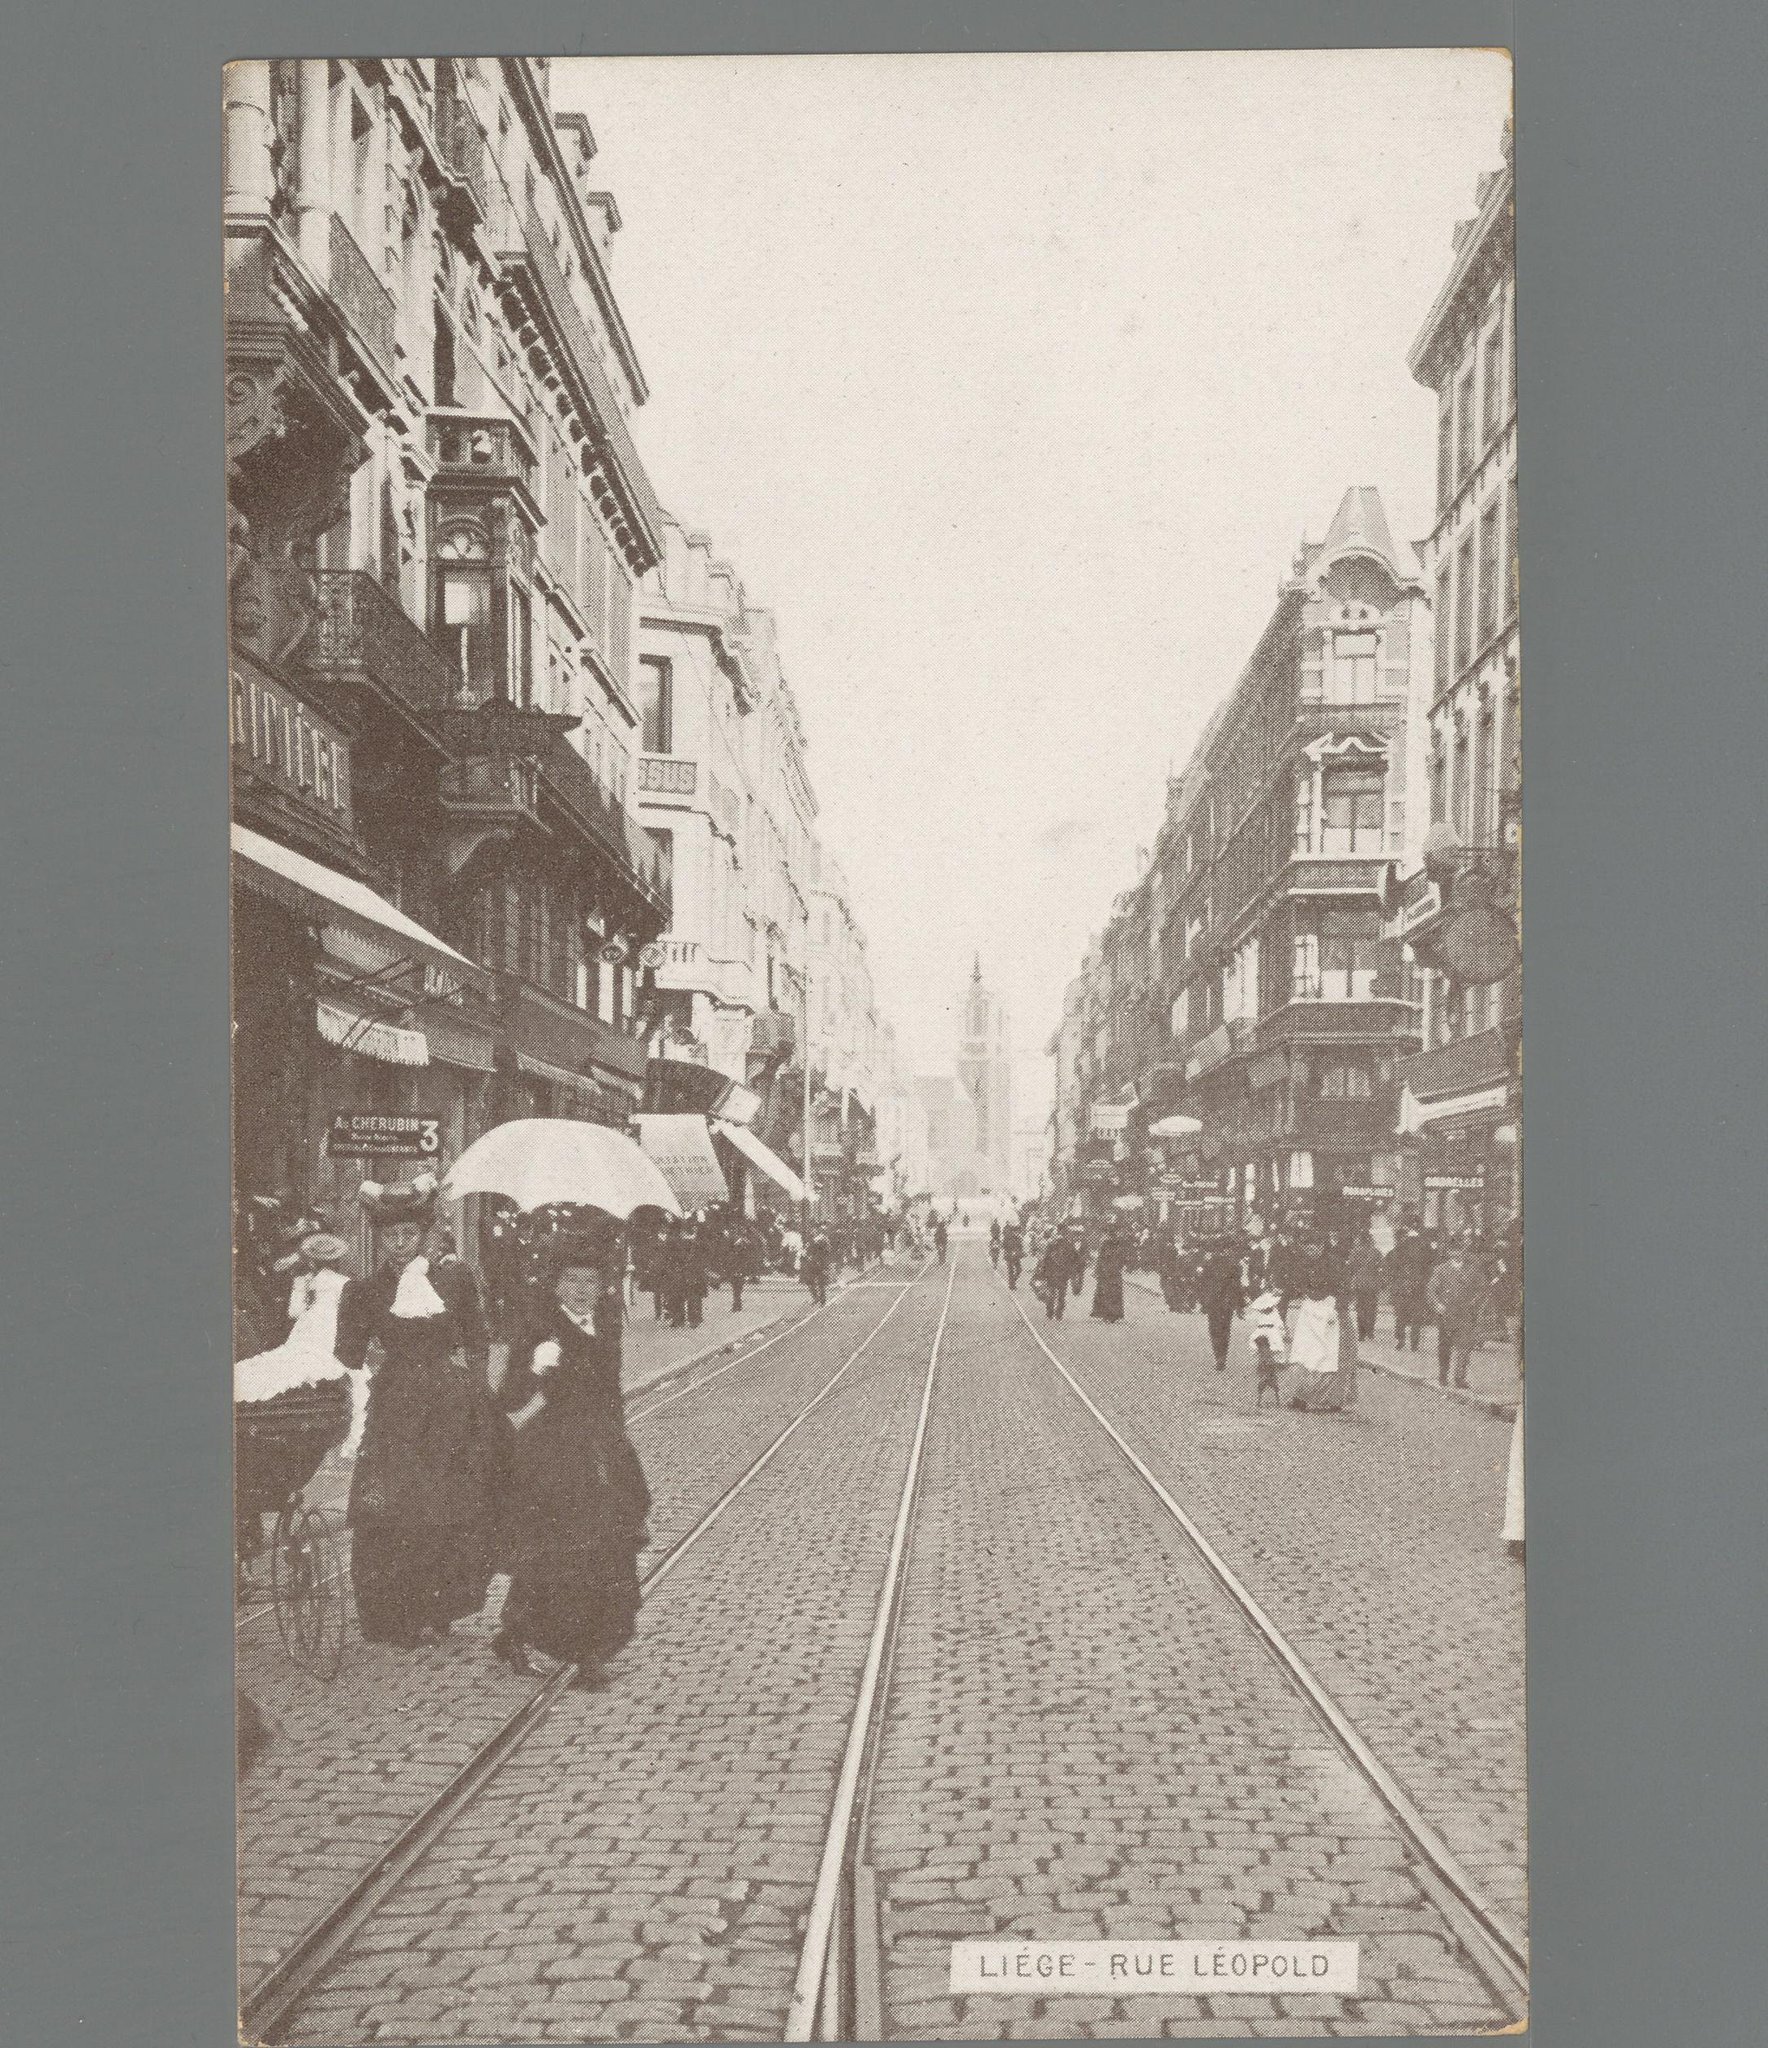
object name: ansichtkaart, prentbriefkaart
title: Liège. Rue Léopold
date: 1909-1913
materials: cardboard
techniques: autotype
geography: antwerp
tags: tramway, tram, street (+ city(-scape) with figures, staffage), liège